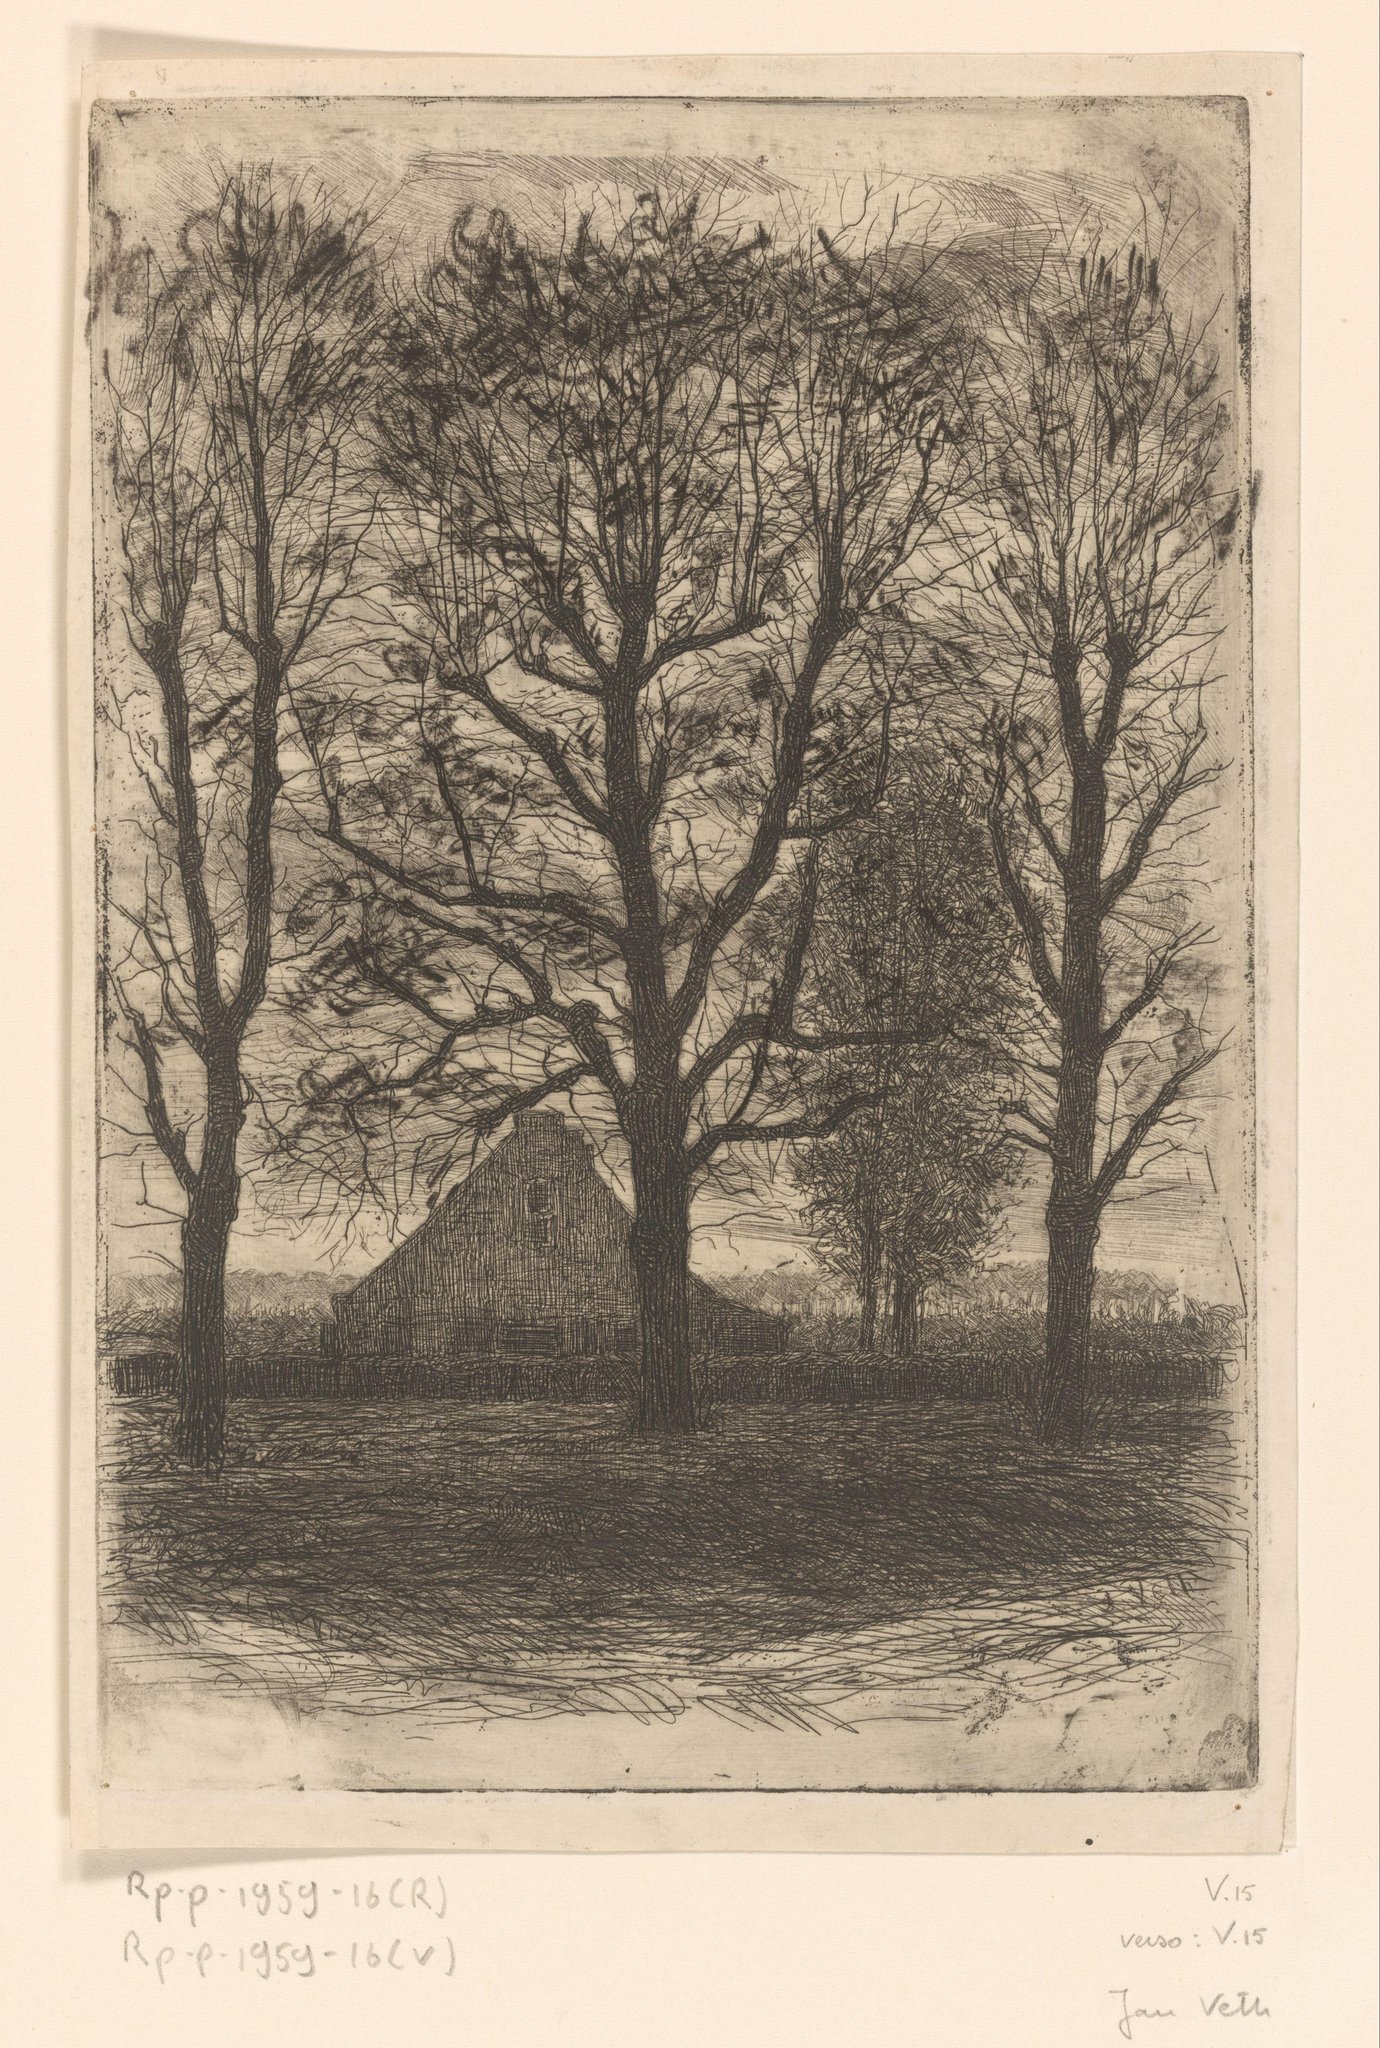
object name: print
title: Boerderij tussen hoge bomen, Ewijkshoeve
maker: jan veth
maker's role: designer, draughtsman, painter, print maker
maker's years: 1864-1925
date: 1886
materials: chalk, paper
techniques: etching, intaglio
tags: farm or solitary house in landscape